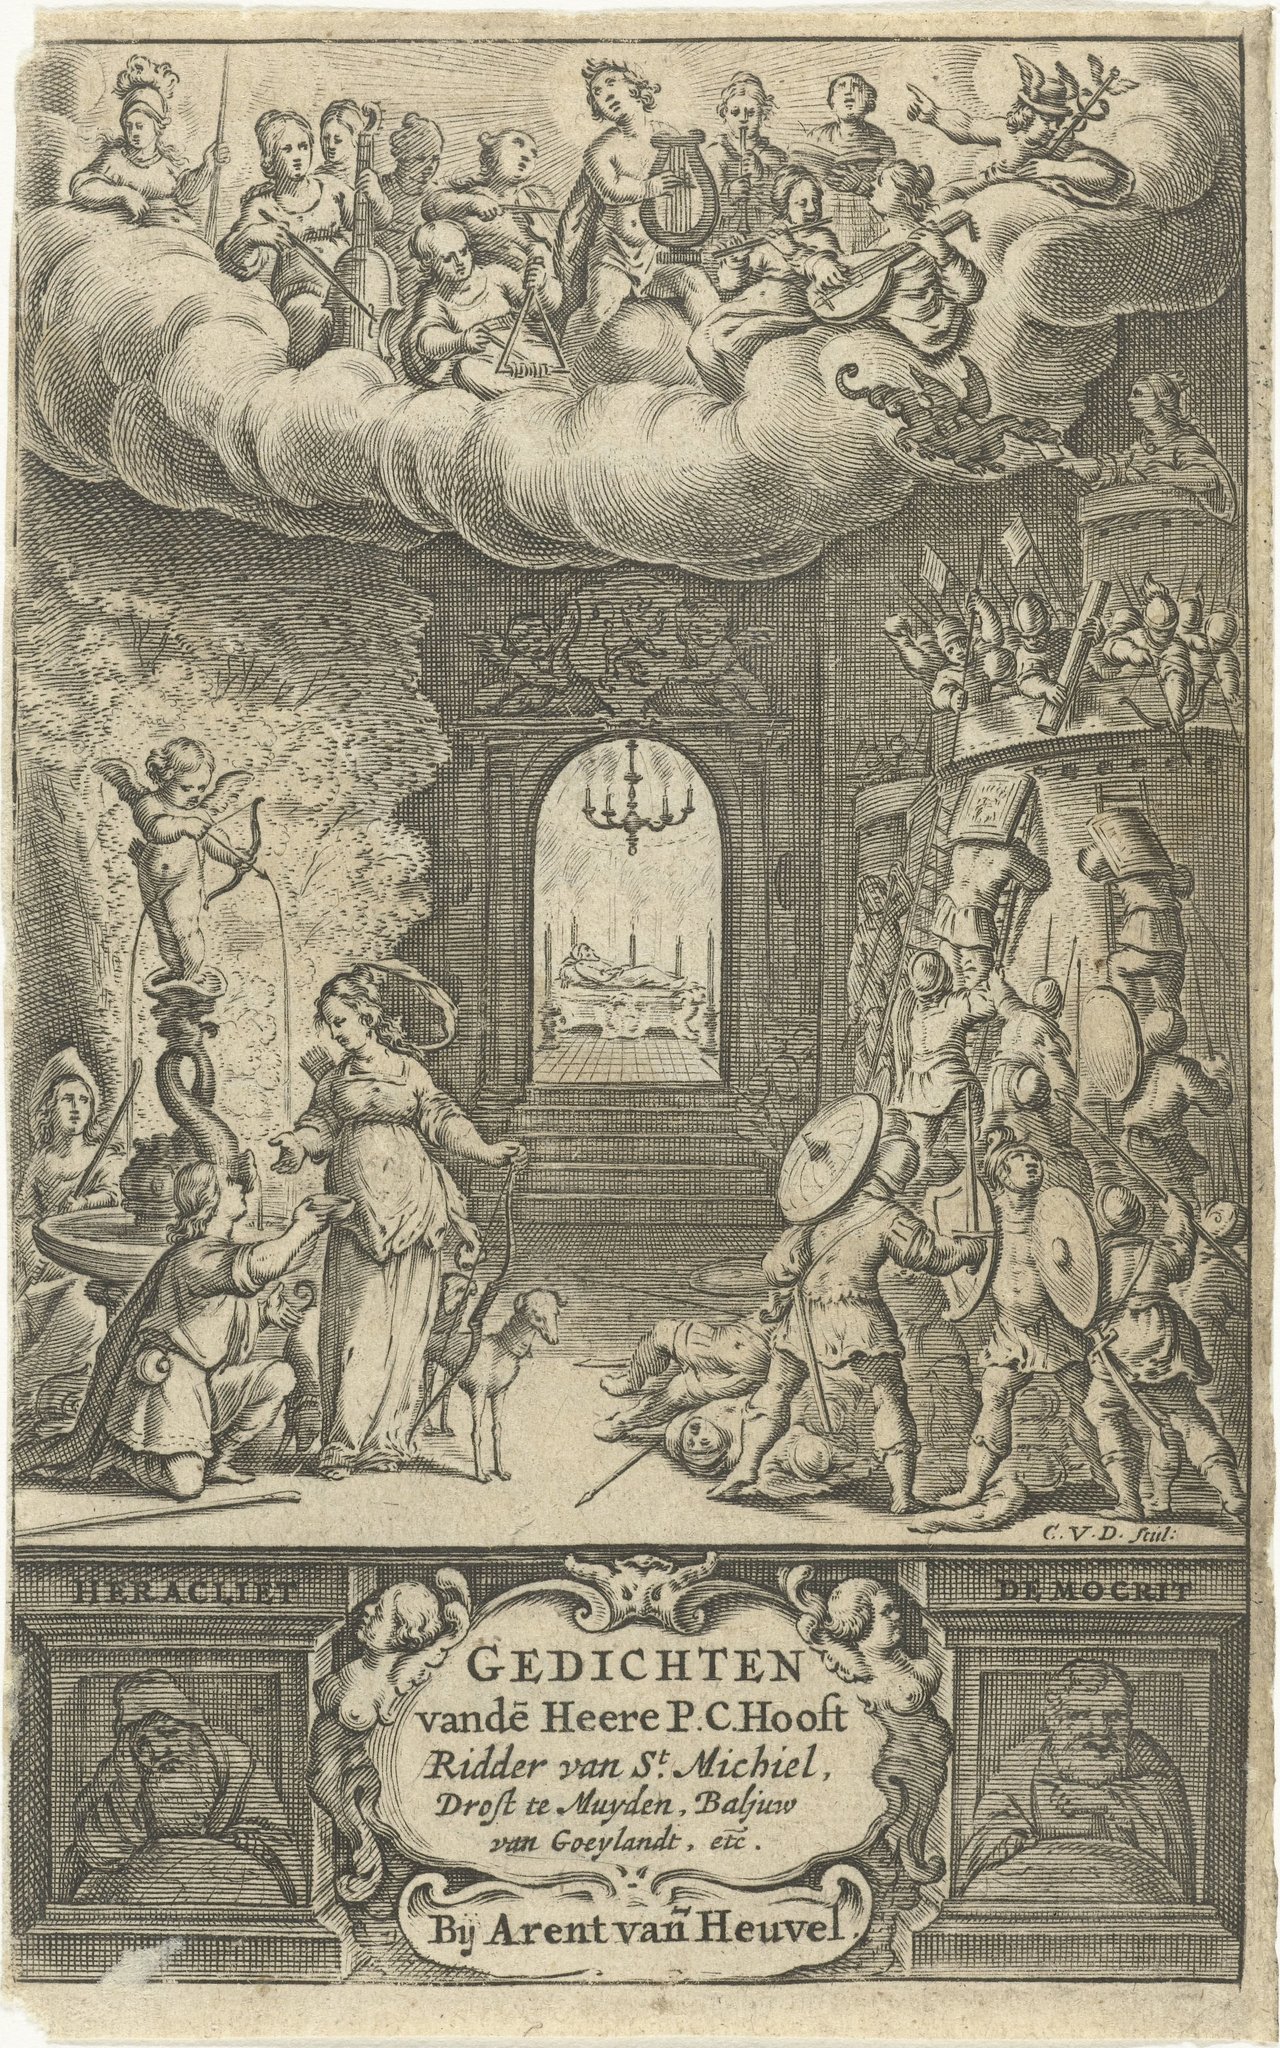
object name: print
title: Gedichten vande Heere P.C. Hooft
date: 1668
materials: paper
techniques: engraving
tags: apollo and the muses, apollo musagetes, (story of) diana (artemis)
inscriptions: collector's mark: Lugt 2228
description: Titelpagina voor: P.C. Hooft, Dichtkunstige werken, Amsterdam, Arent van den Heuvel (uitgever) 1668